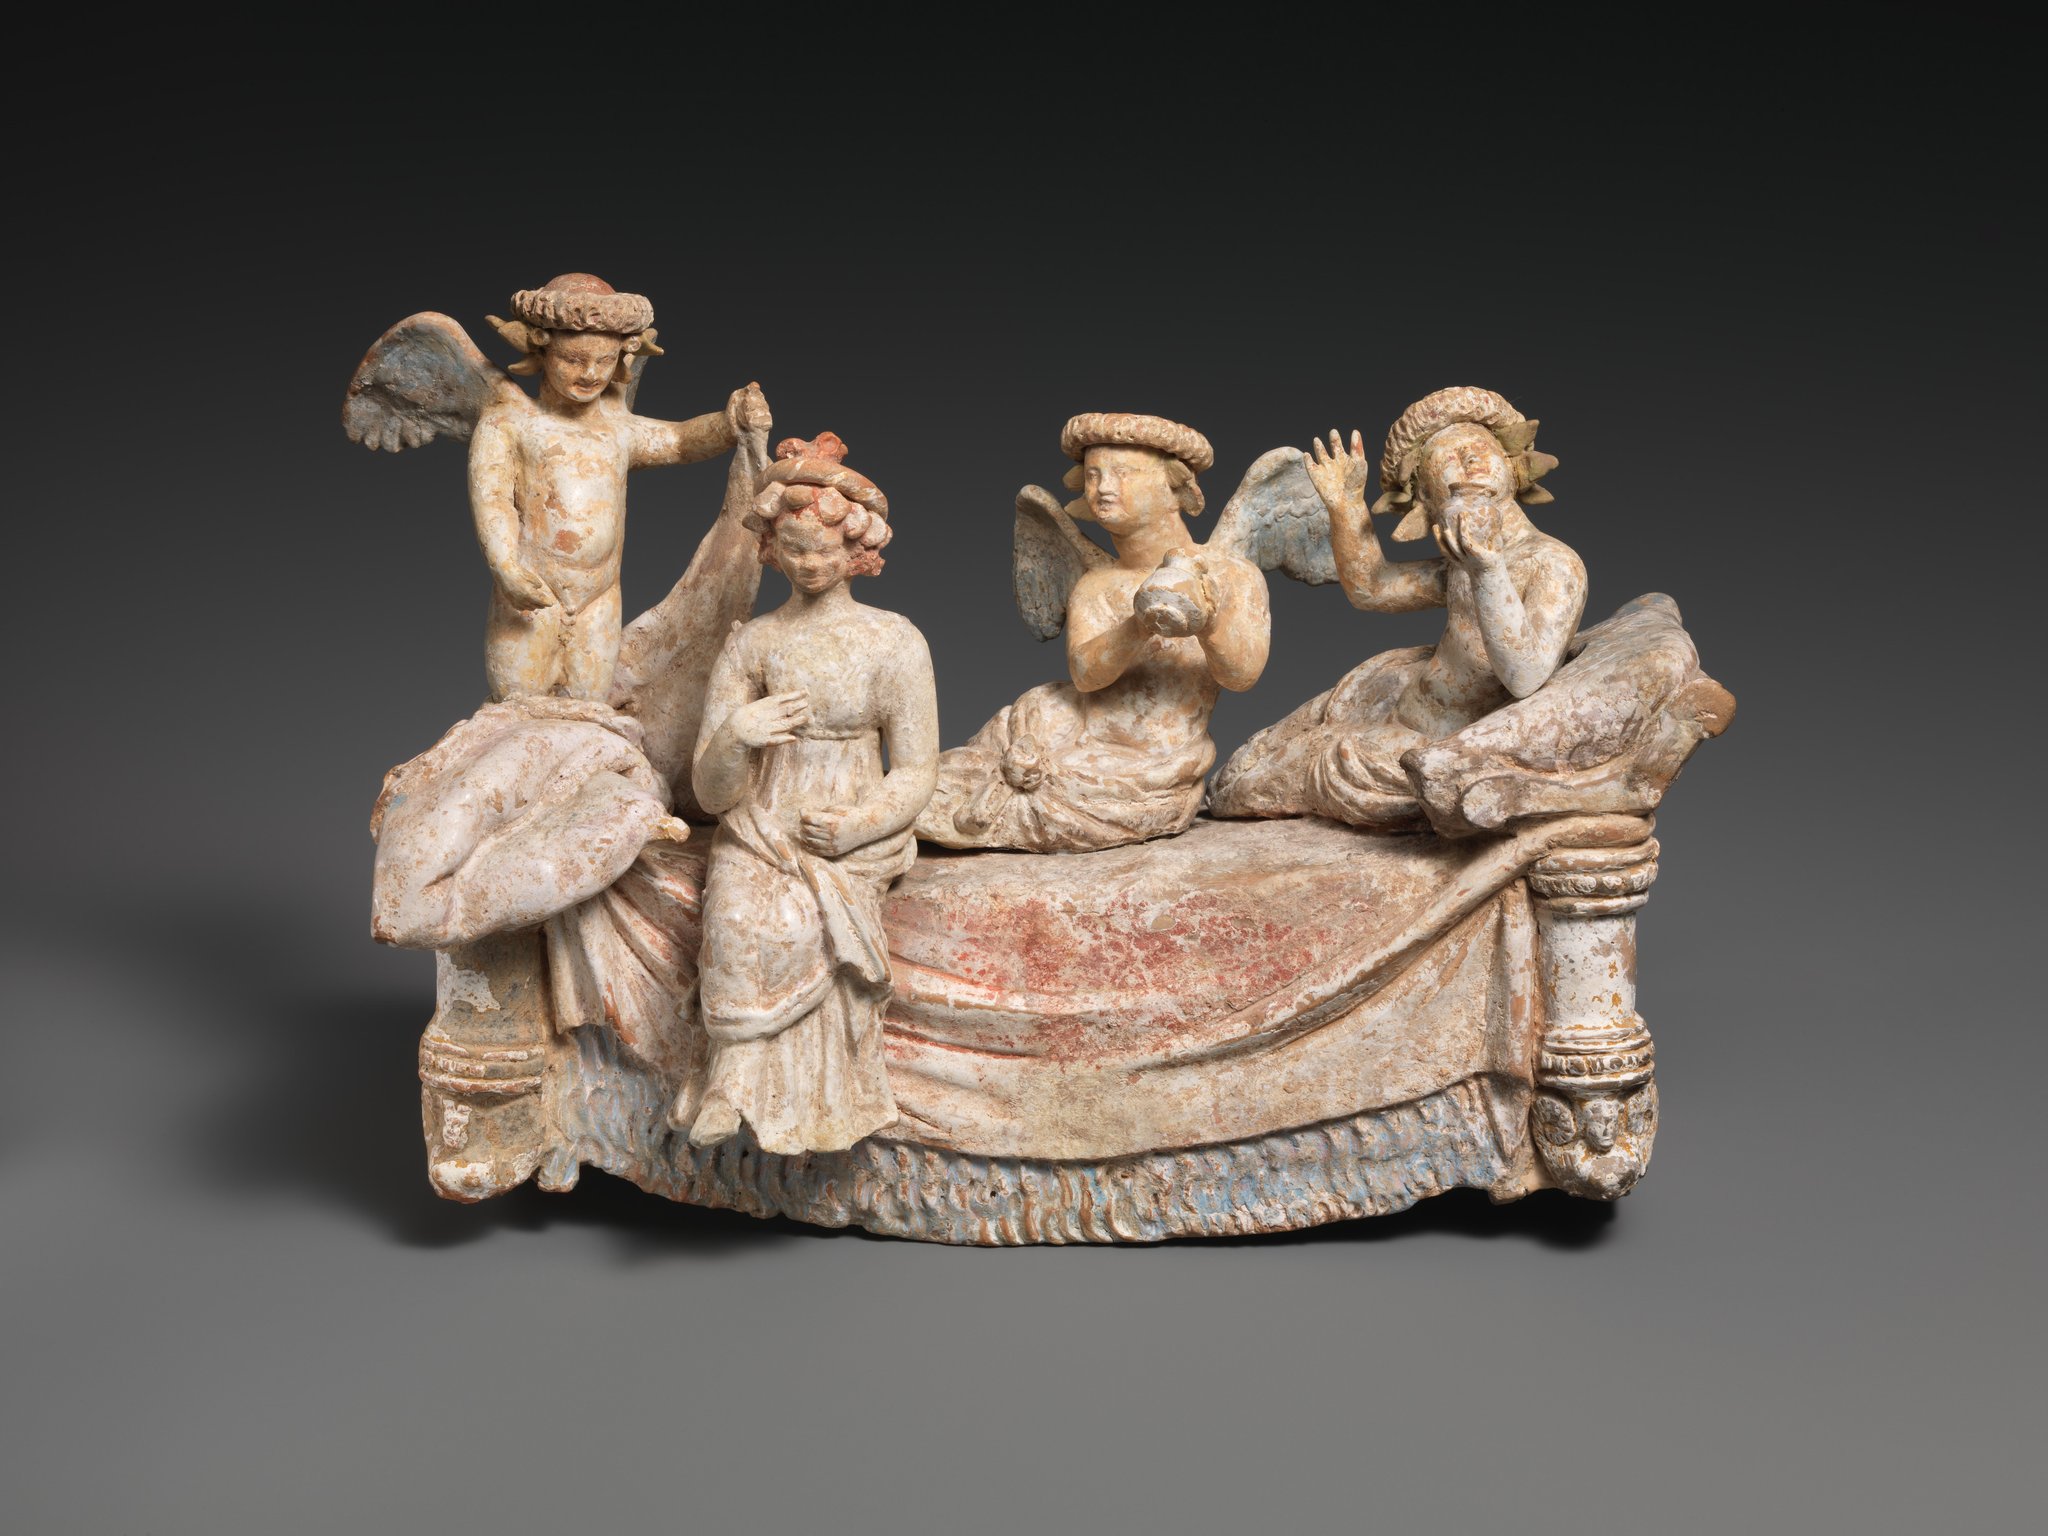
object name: terracotta group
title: Terracotta Banquet Group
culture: greek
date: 300-101 BCE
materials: terracotta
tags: men,women,eros,drinking,couches